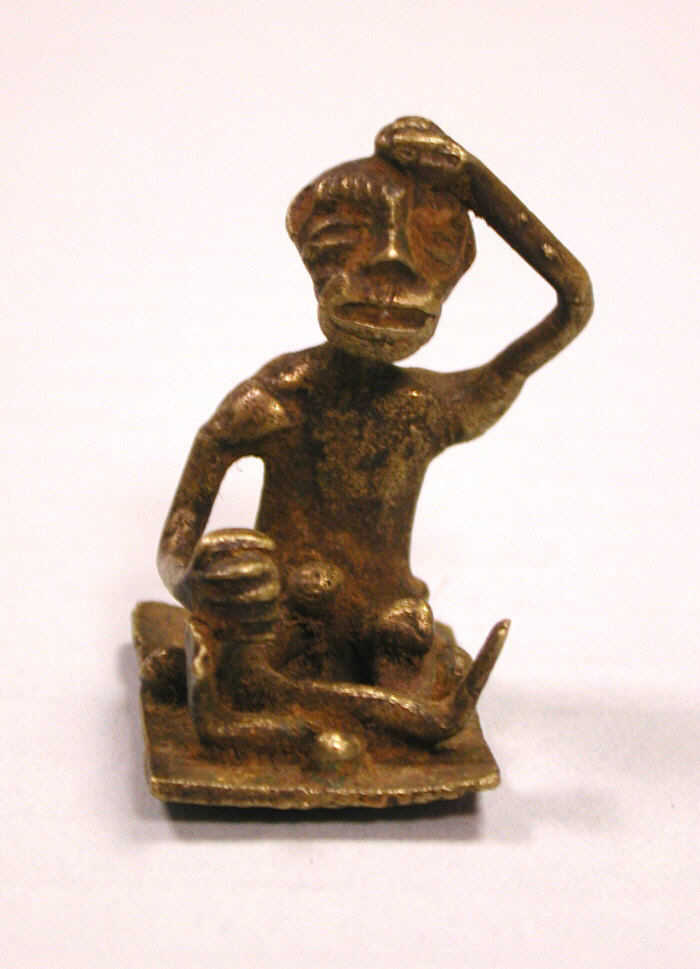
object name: weight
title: Gold Weight: Seated Male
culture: akan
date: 1701-1900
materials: brass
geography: ghana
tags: men